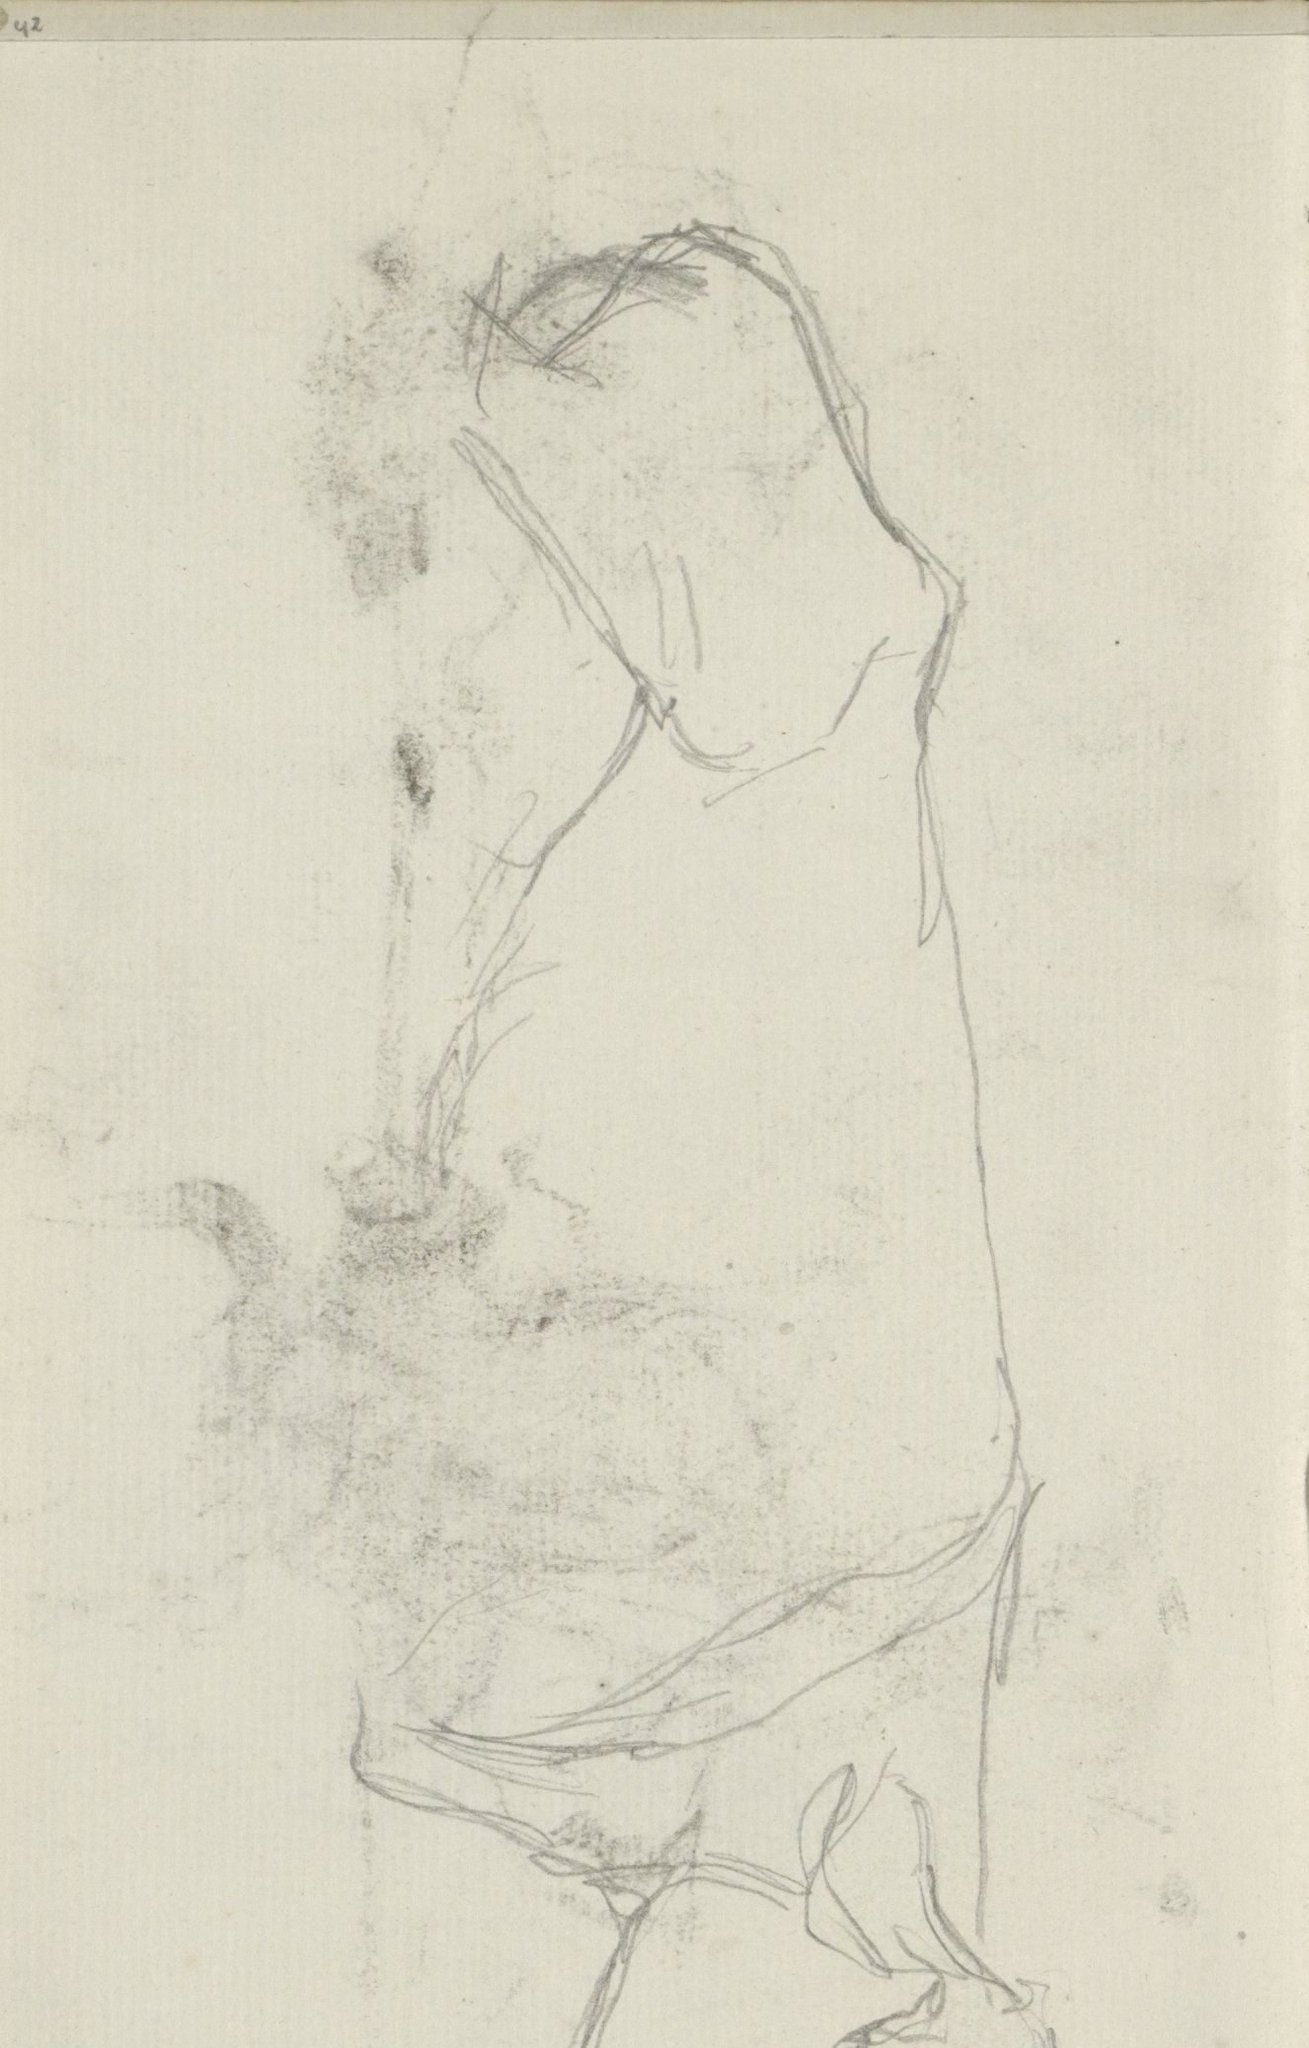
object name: sketchbook leaf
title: Koe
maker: george hendrik breitner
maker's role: draughtsman, painter, print maker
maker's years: 1857-1923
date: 1880-1882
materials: paper, pencil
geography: the hague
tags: cow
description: Pagina 42 uit een schetsboek met 25 bladen.